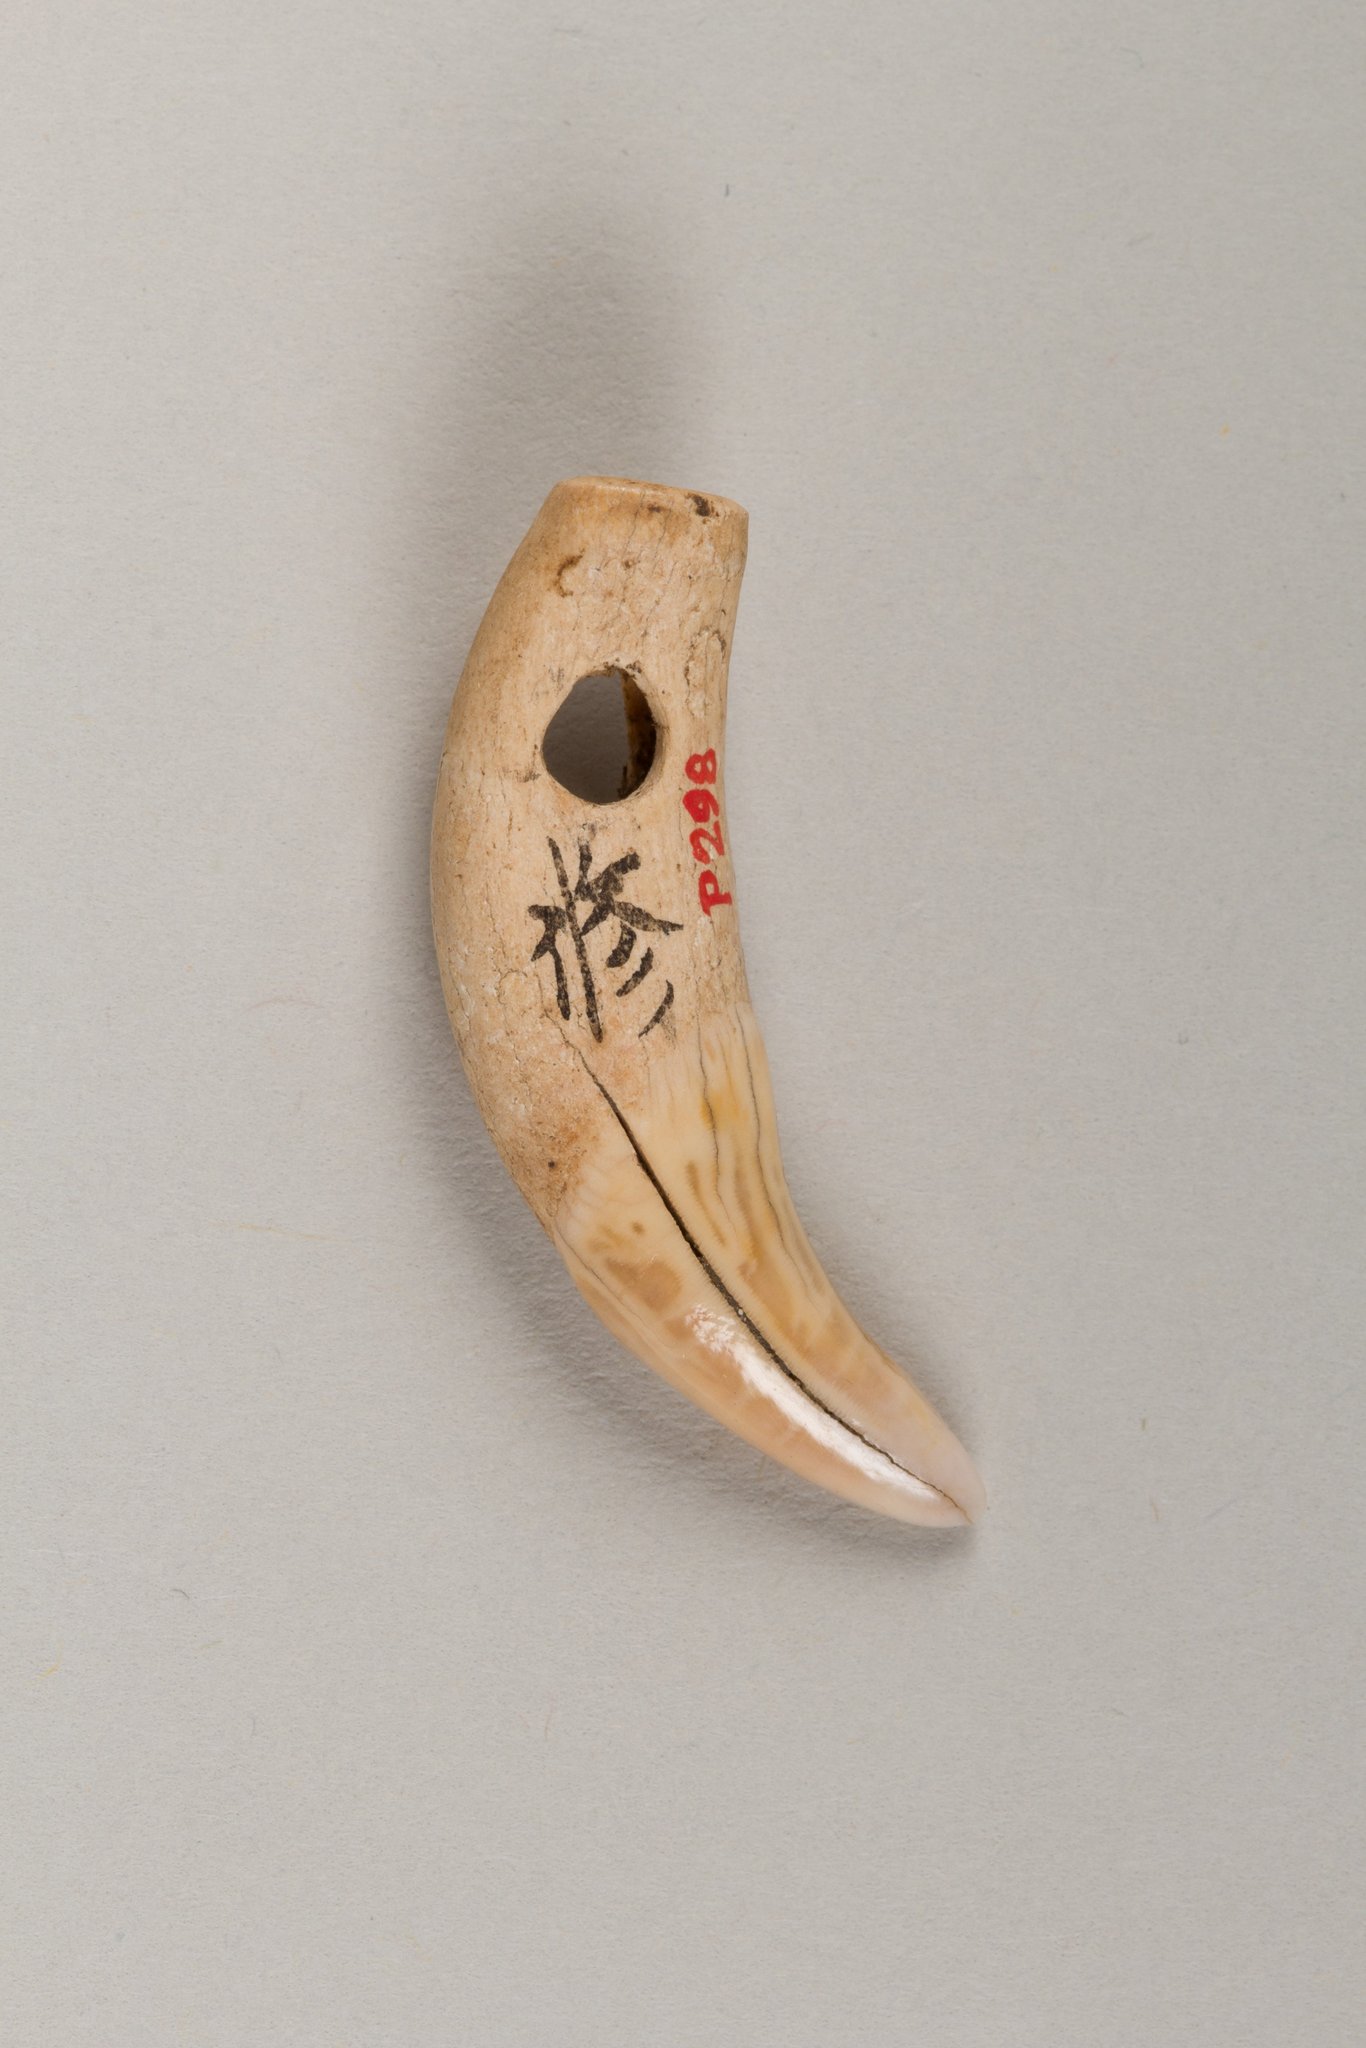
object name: body ornament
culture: japanese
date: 1000-300 BCE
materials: bone